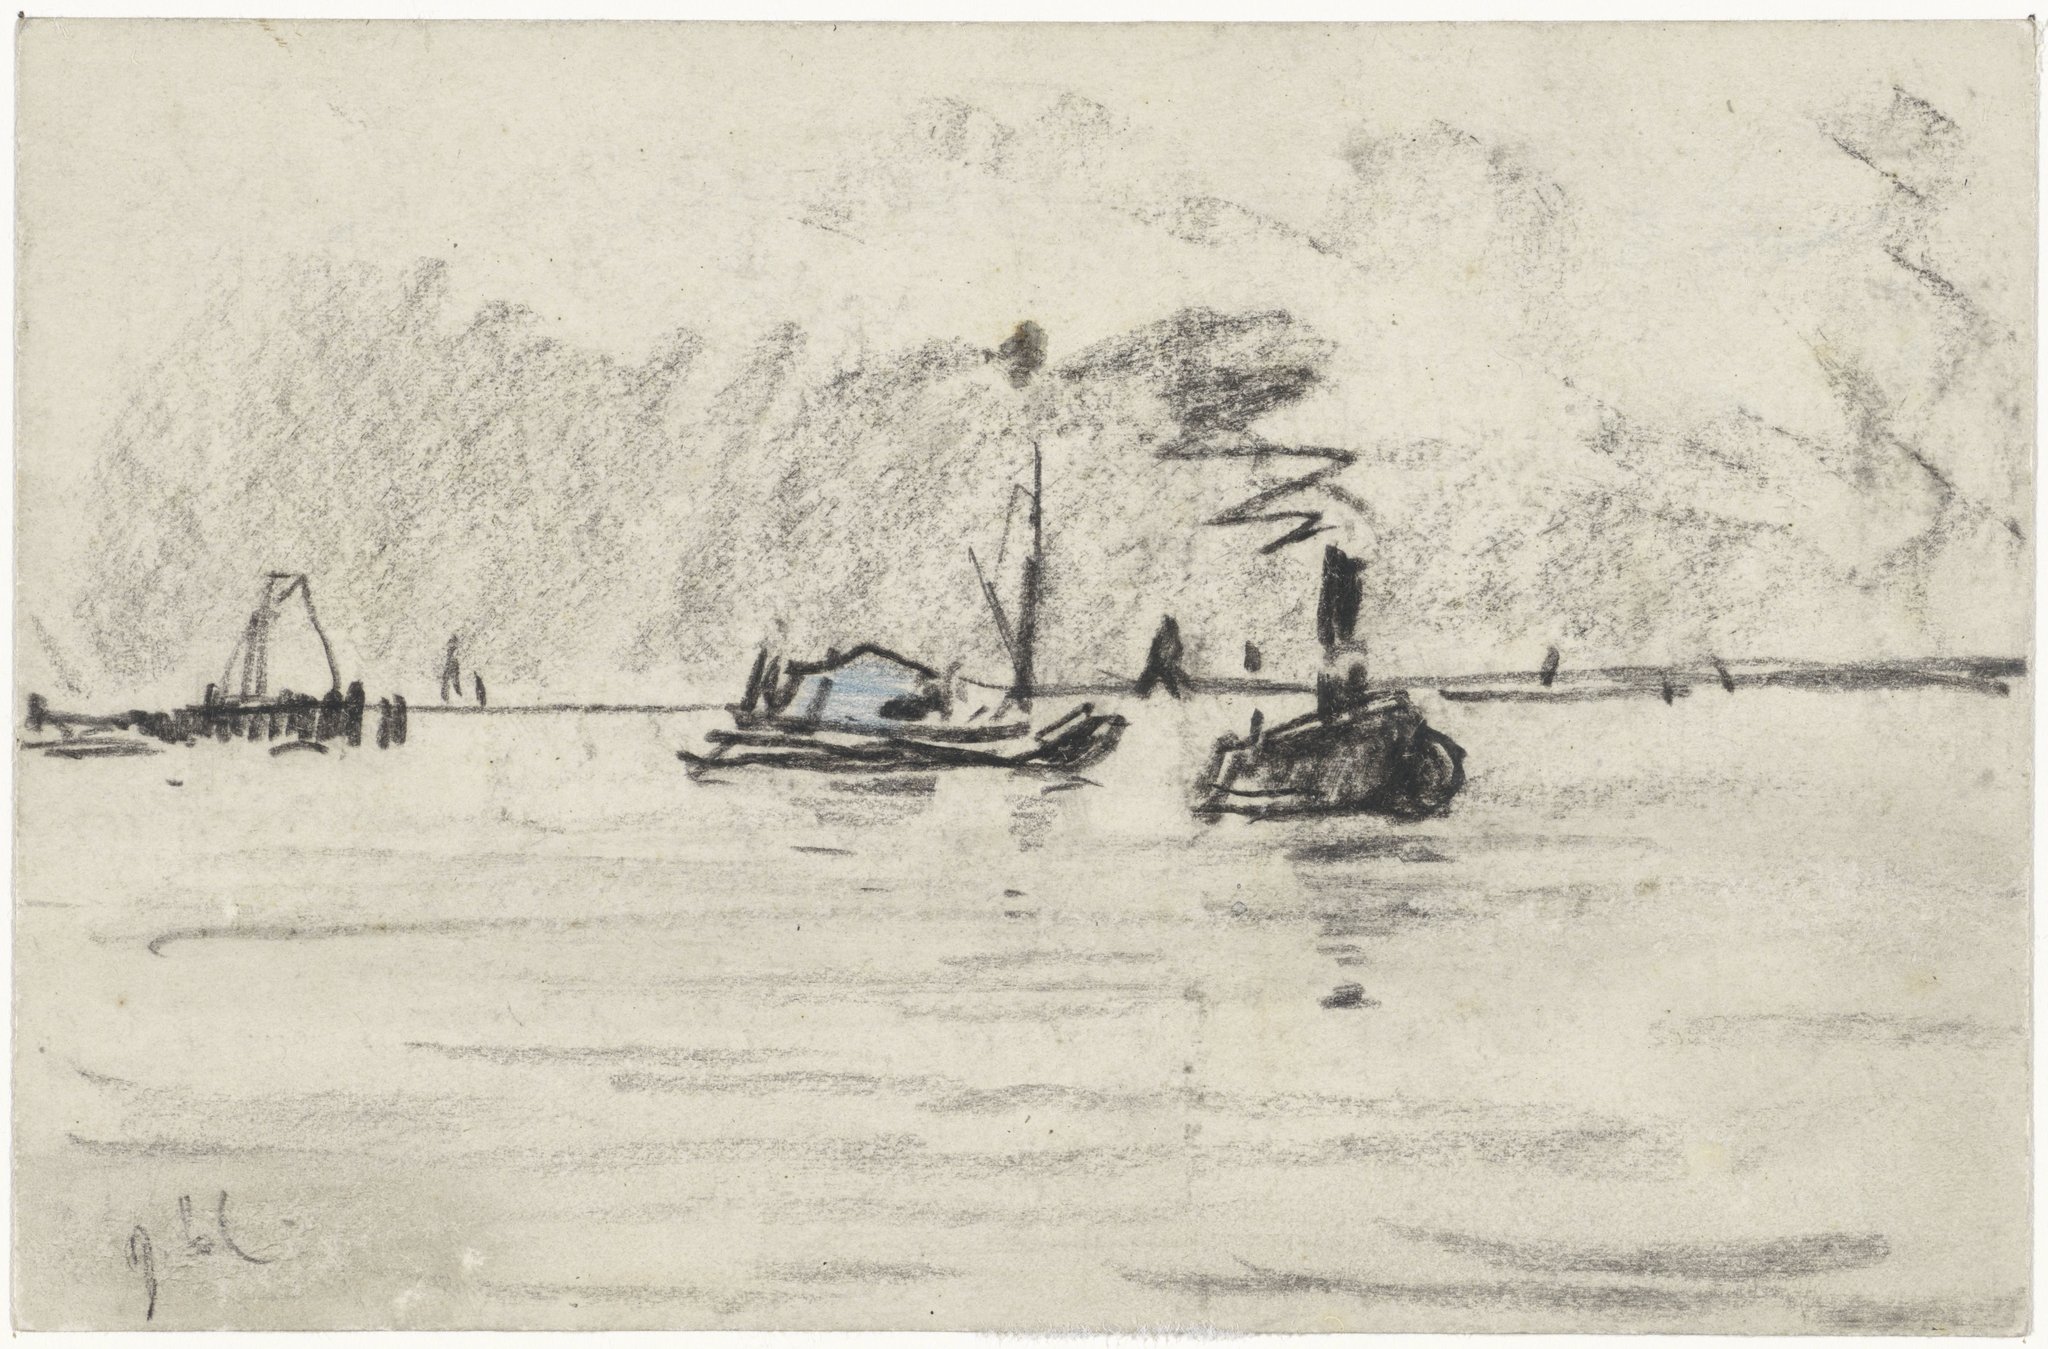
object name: drawing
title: Sleepboot op rivier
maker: adolf le comte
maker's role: draughtsman, painter, print maker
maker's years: 1850-1921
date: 1860-1921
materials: chalk, paper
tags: tug, pusher tug